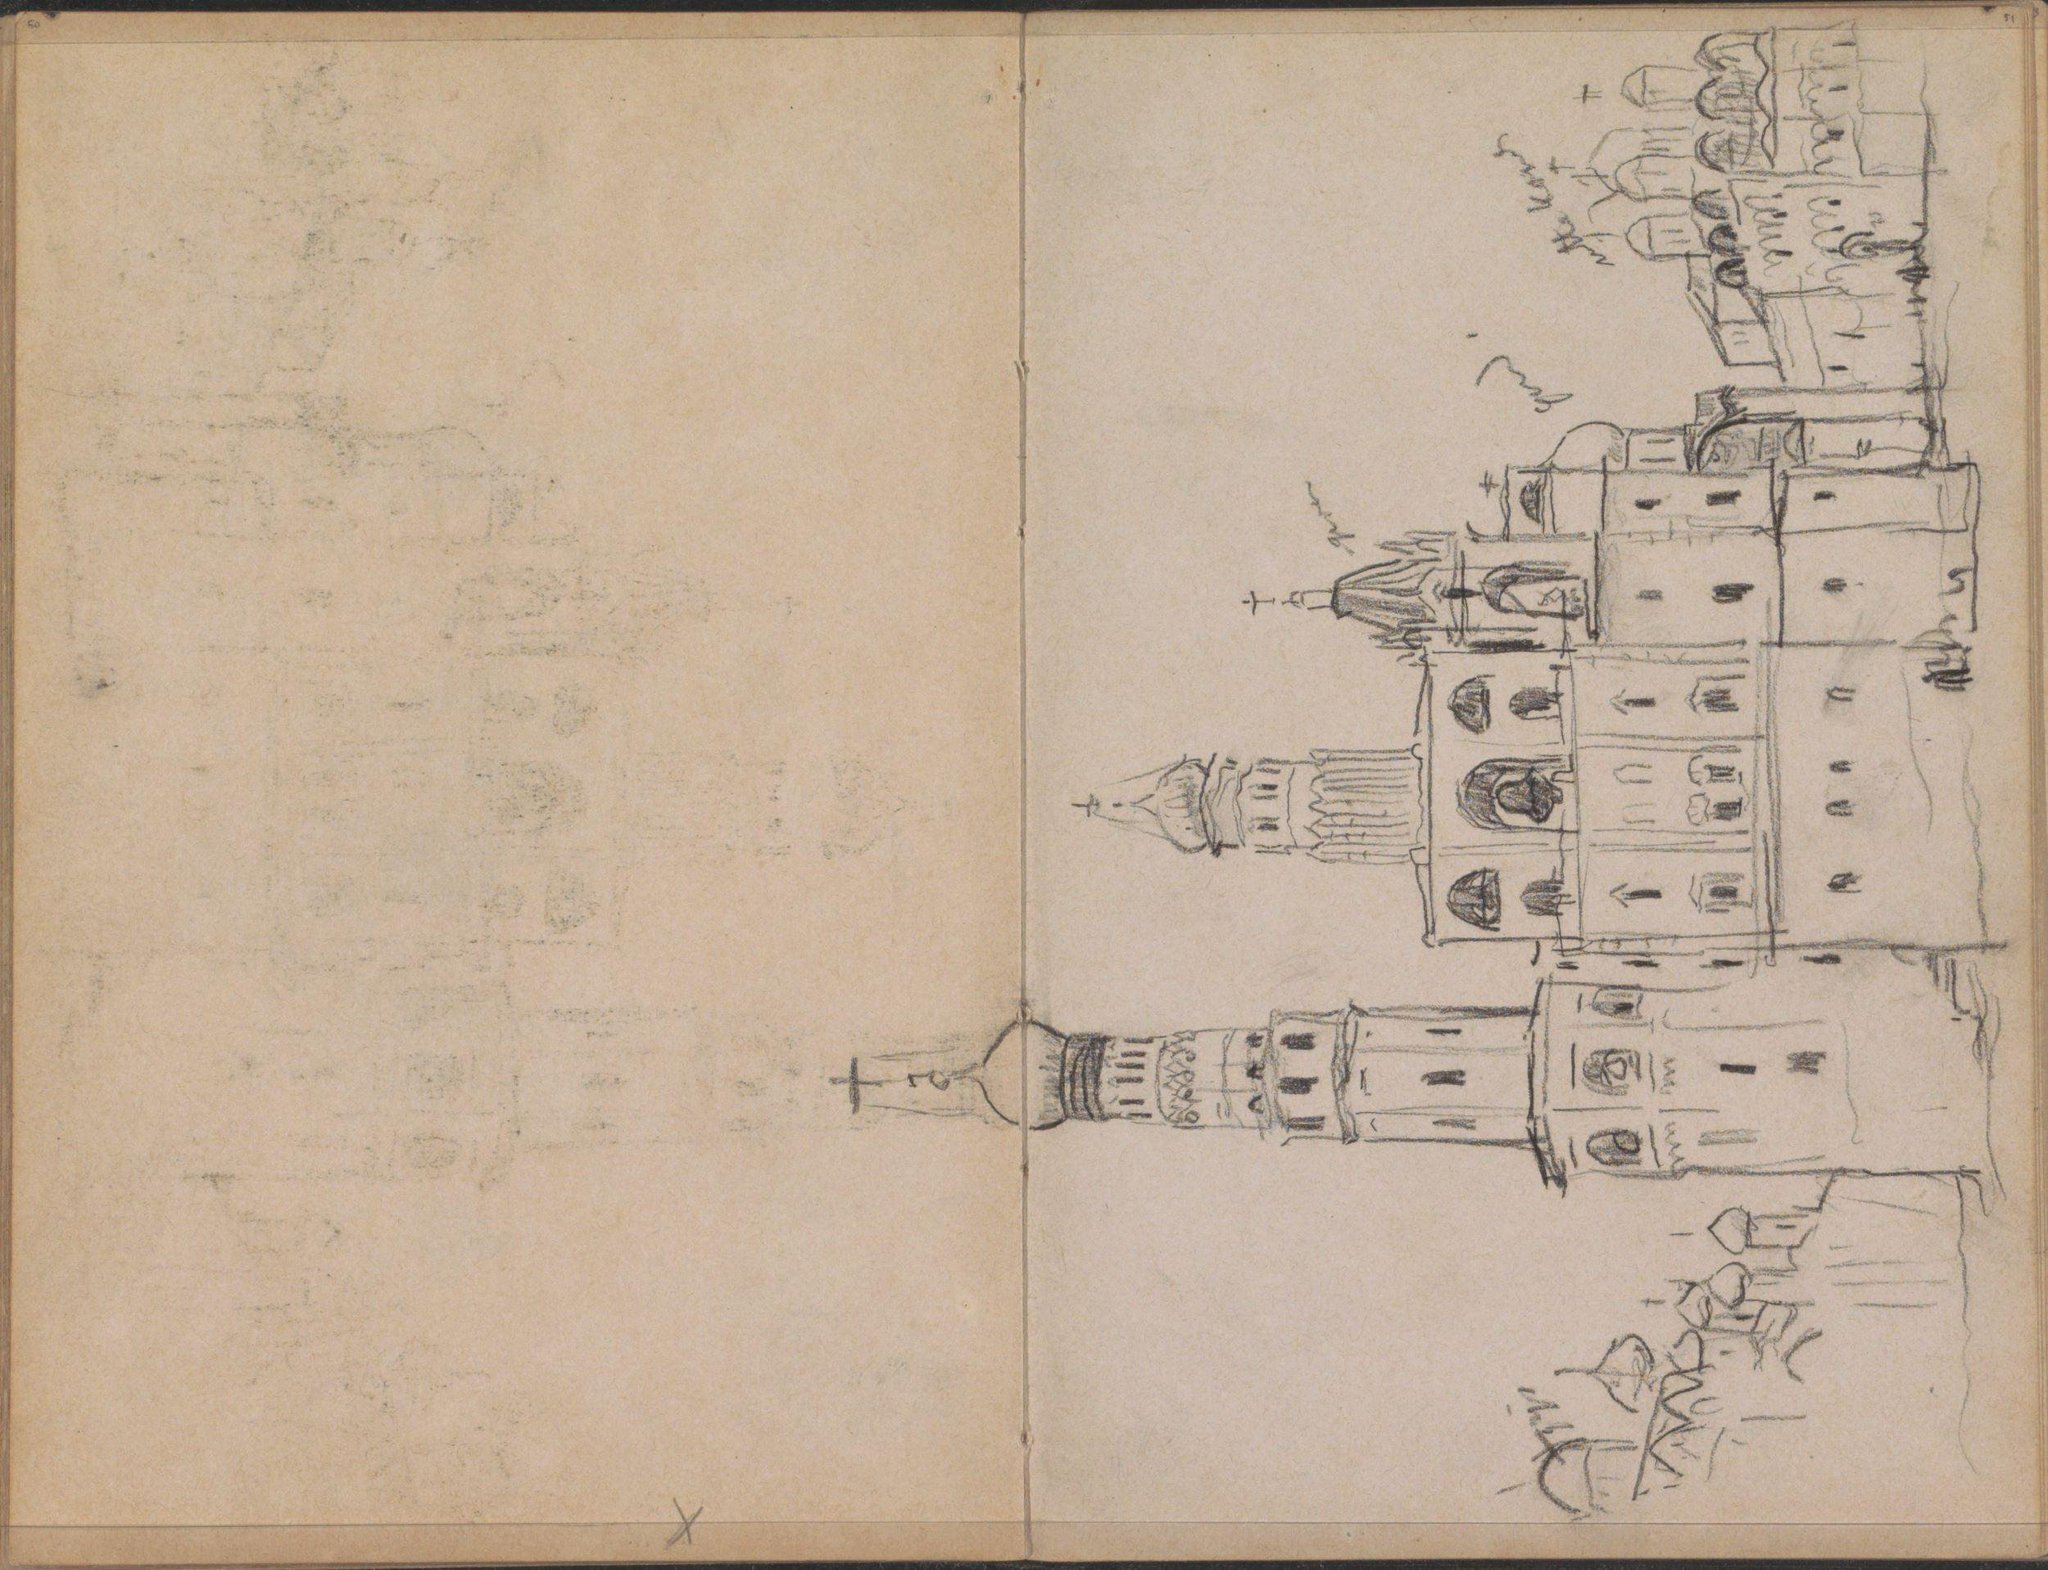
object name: sketchbook leaf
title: Klokkentoren van Ivan de Grote te Moskou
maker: marius bauer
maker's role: draughtsman, print maker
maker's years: 1867-1932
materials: chalk, paper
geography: moscow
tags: church bell, tower (of house or building)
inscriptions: kleurnotitie, handgeschreven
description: Pagina 50 en 51 uit een schetsboek met 54 bladen.